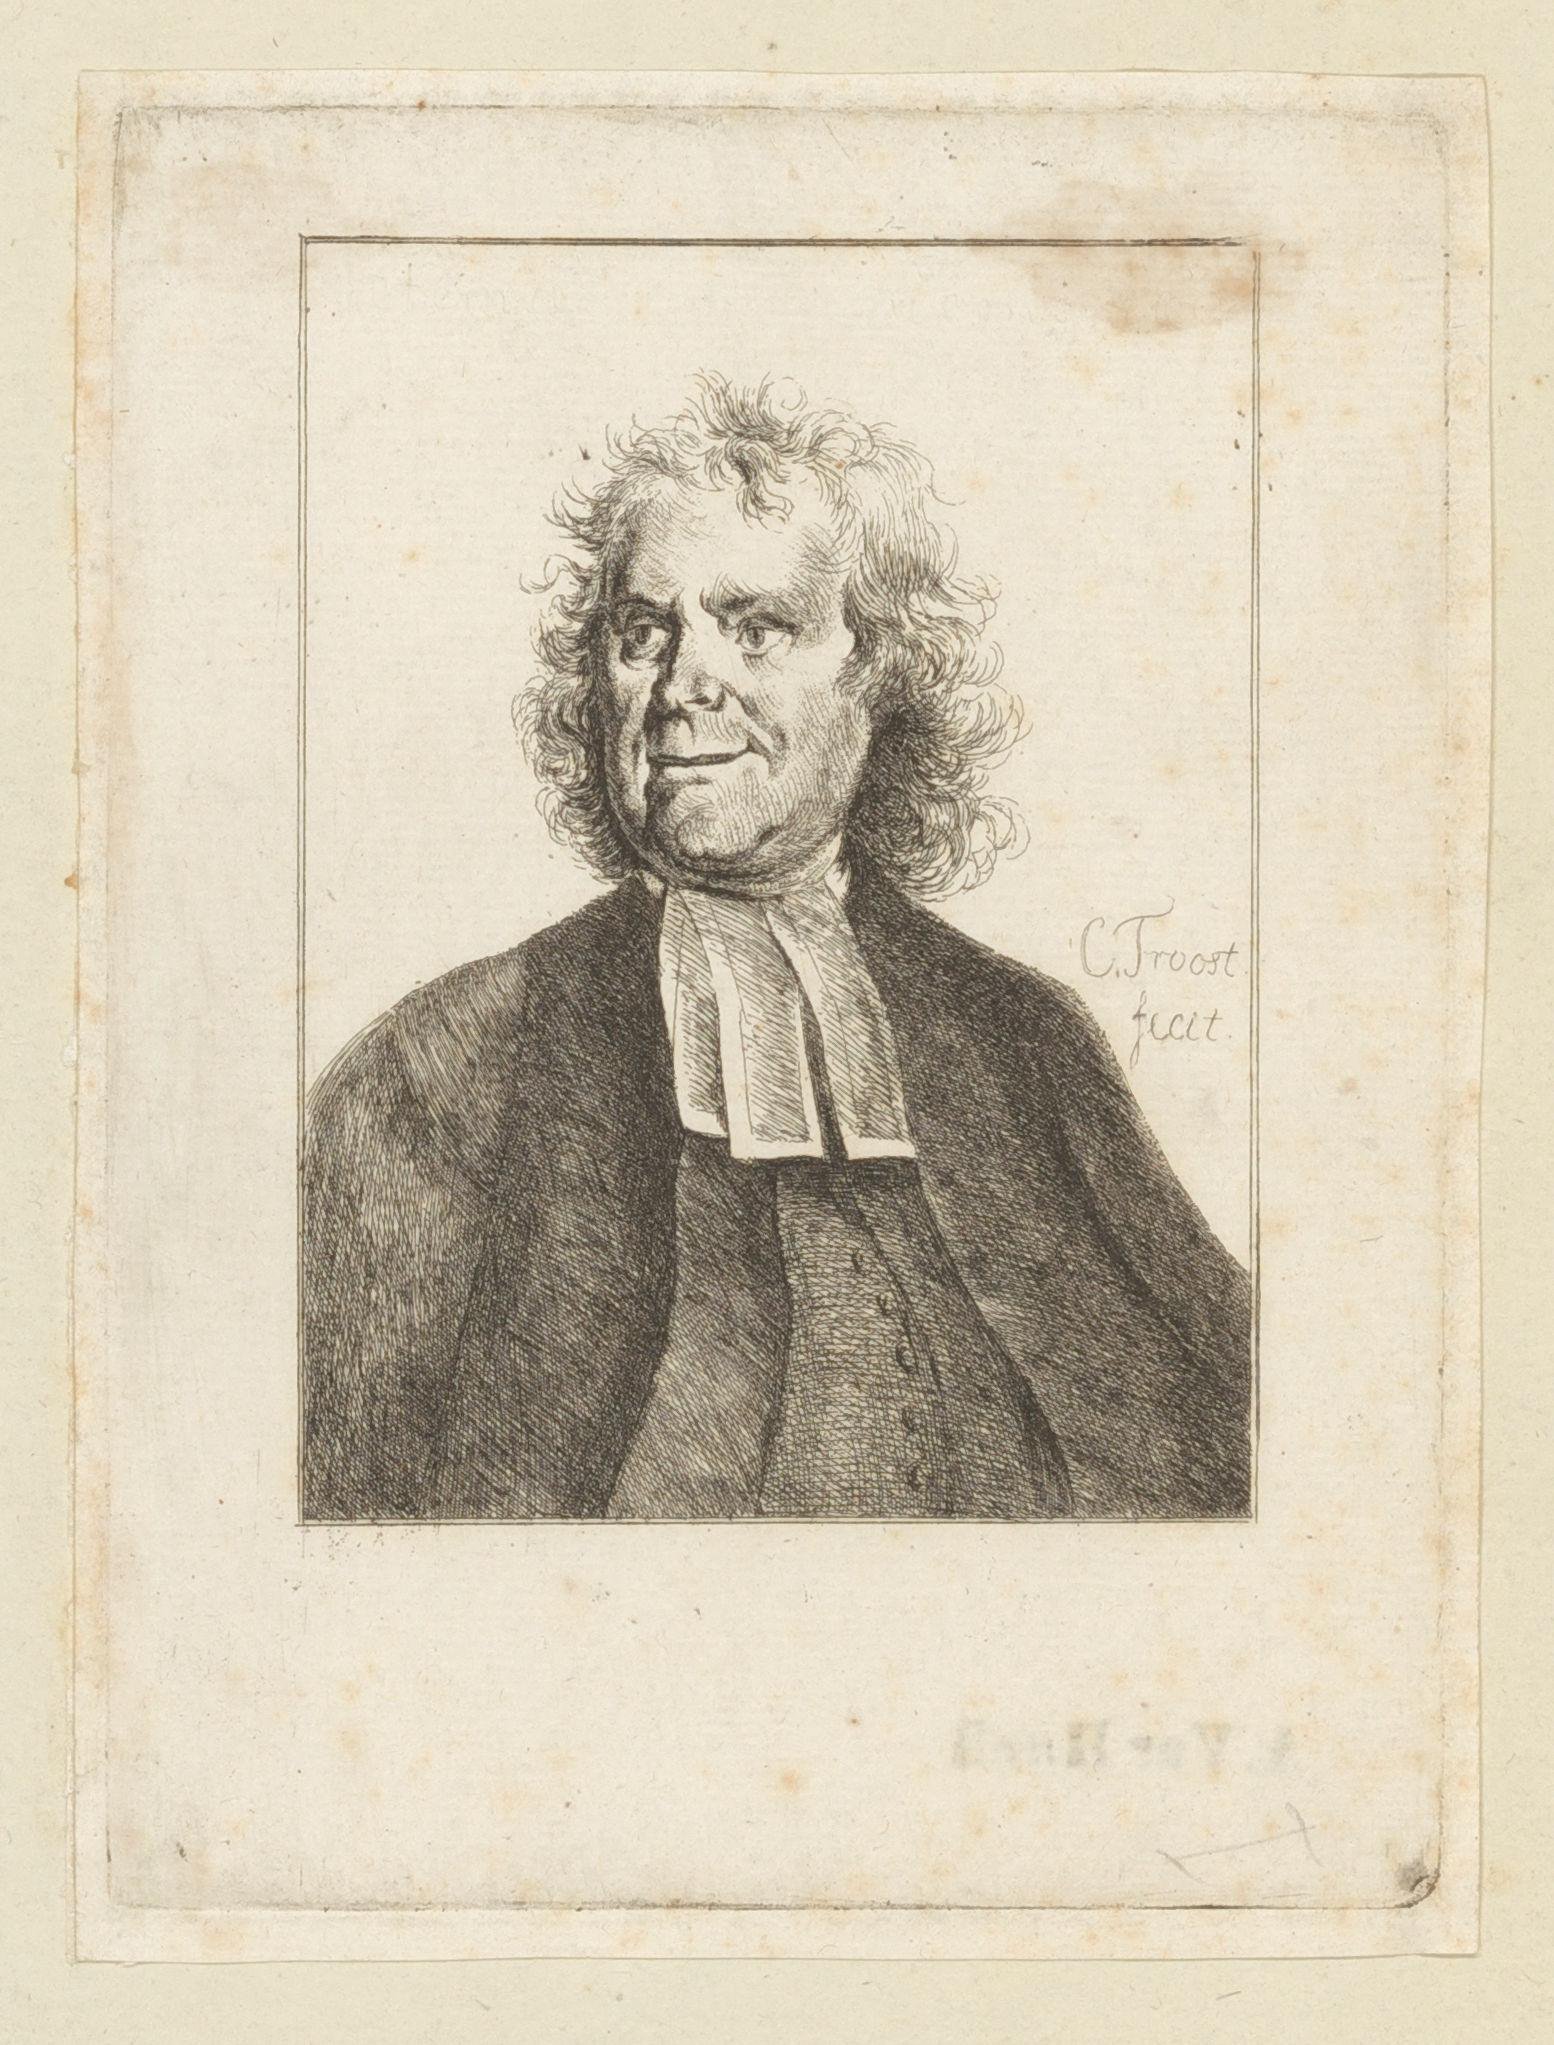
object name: print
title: Portret van Hermanus Boerhaave (versie B)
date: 1762-1782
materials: paper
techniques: etching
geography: the hague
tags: leiden, hermanus boerhaave, historical persons, physician, doctor (+ scholar, scientist (at work))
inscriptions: collector's mark: Lugt 2488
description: Portret van Hermanus Boerhaave, buste, driekwart naar rechts. Versie B van het portret, door Heenck. Samen met drie andere versies van deze prent opgezet op een blad met een handschrift met de anekdote over het aan stukken snijden van de koperplaat door de dochter van Boerhaave.